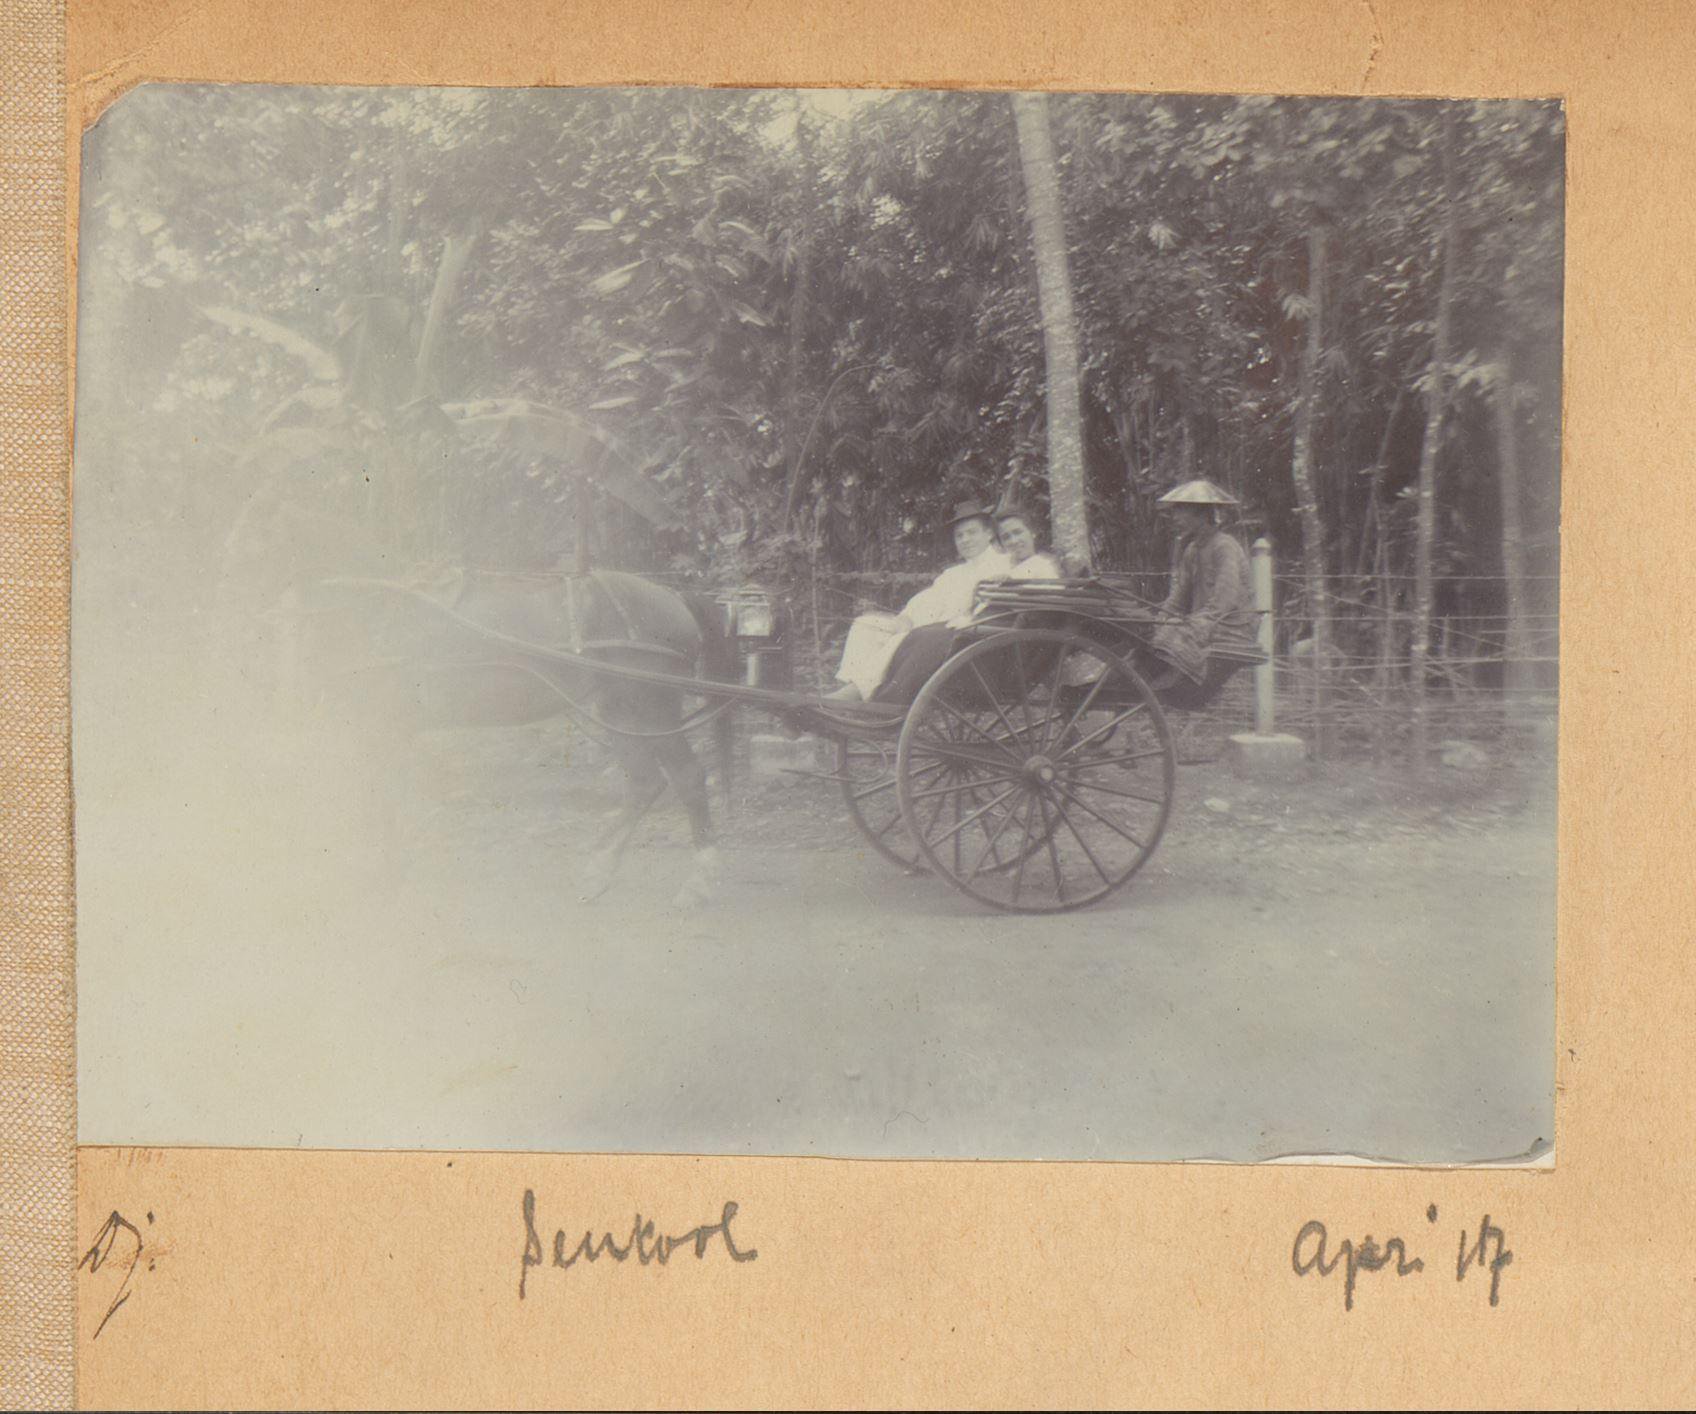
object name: photograph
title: Europees stel in een rijtuig in Sentool op Java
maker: Anonymous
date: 1904-1917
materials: photographic support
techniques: gelatin silver print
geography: java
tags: two-wheeled, animal-drawn vehicle, java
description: Onderdeel van Familiealbum met foto's van een familie in de voormalige kolonie Nederlands-Indië en van een suikerfabriek in Purworejo.